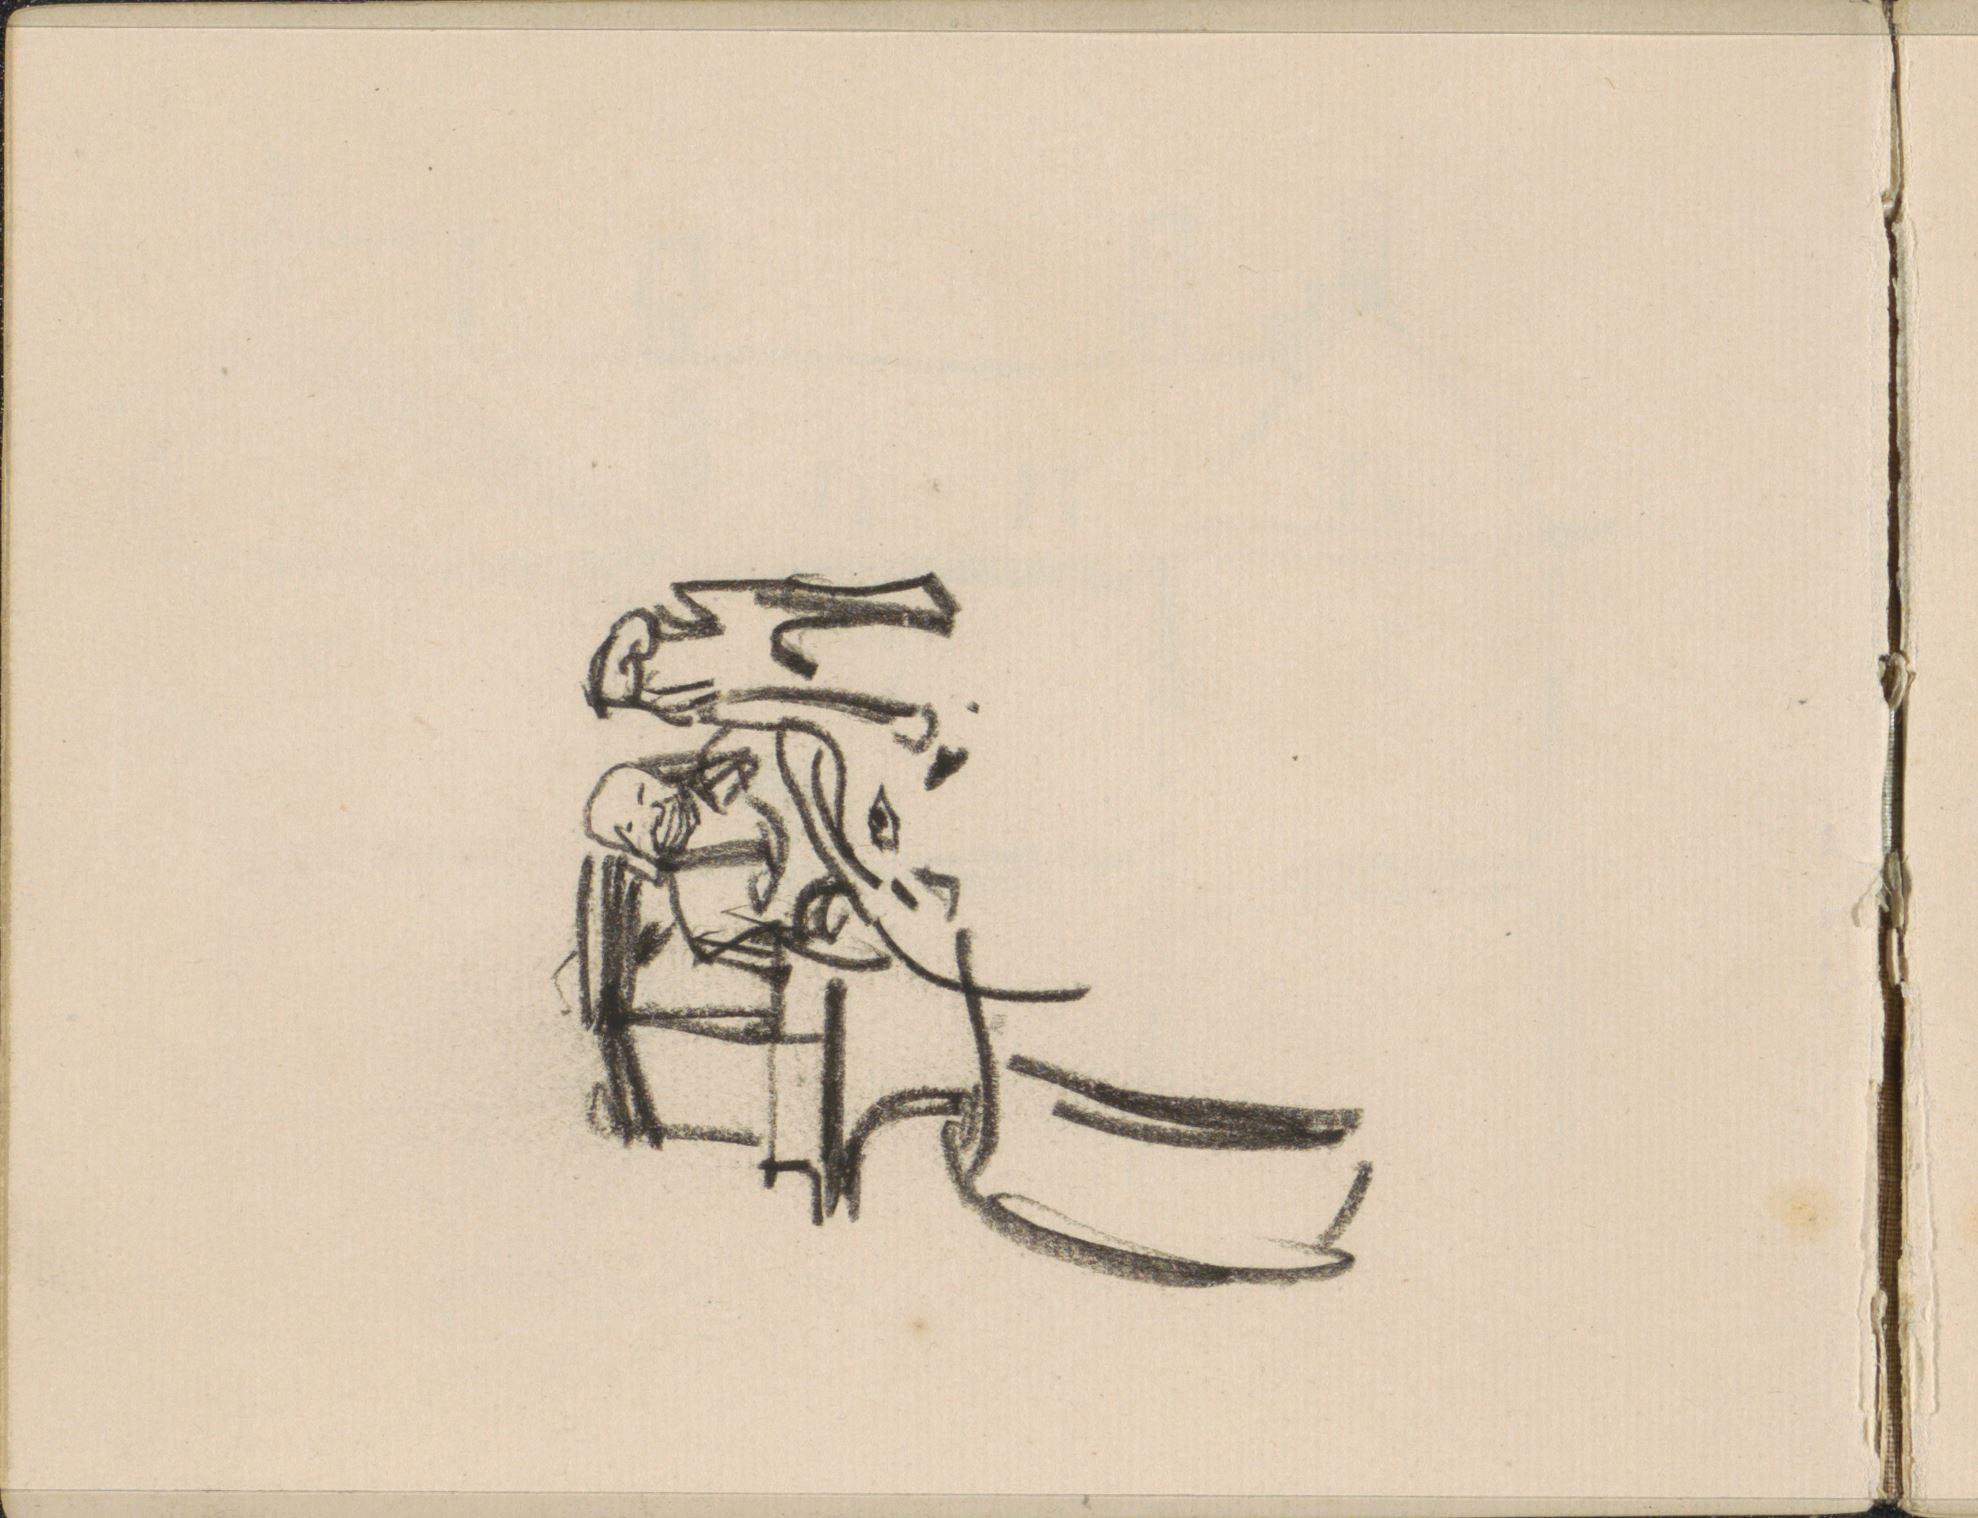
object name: sketchbook leaf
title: Studie met figuren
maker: george hendrik breitner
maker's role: draughtsman, painter, print maker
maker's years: 1857-1923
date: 1886-1903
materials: chalk, paper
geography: amsterdam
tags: adult man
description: Pagina 15 uit een schetsboek met 32 bladen.